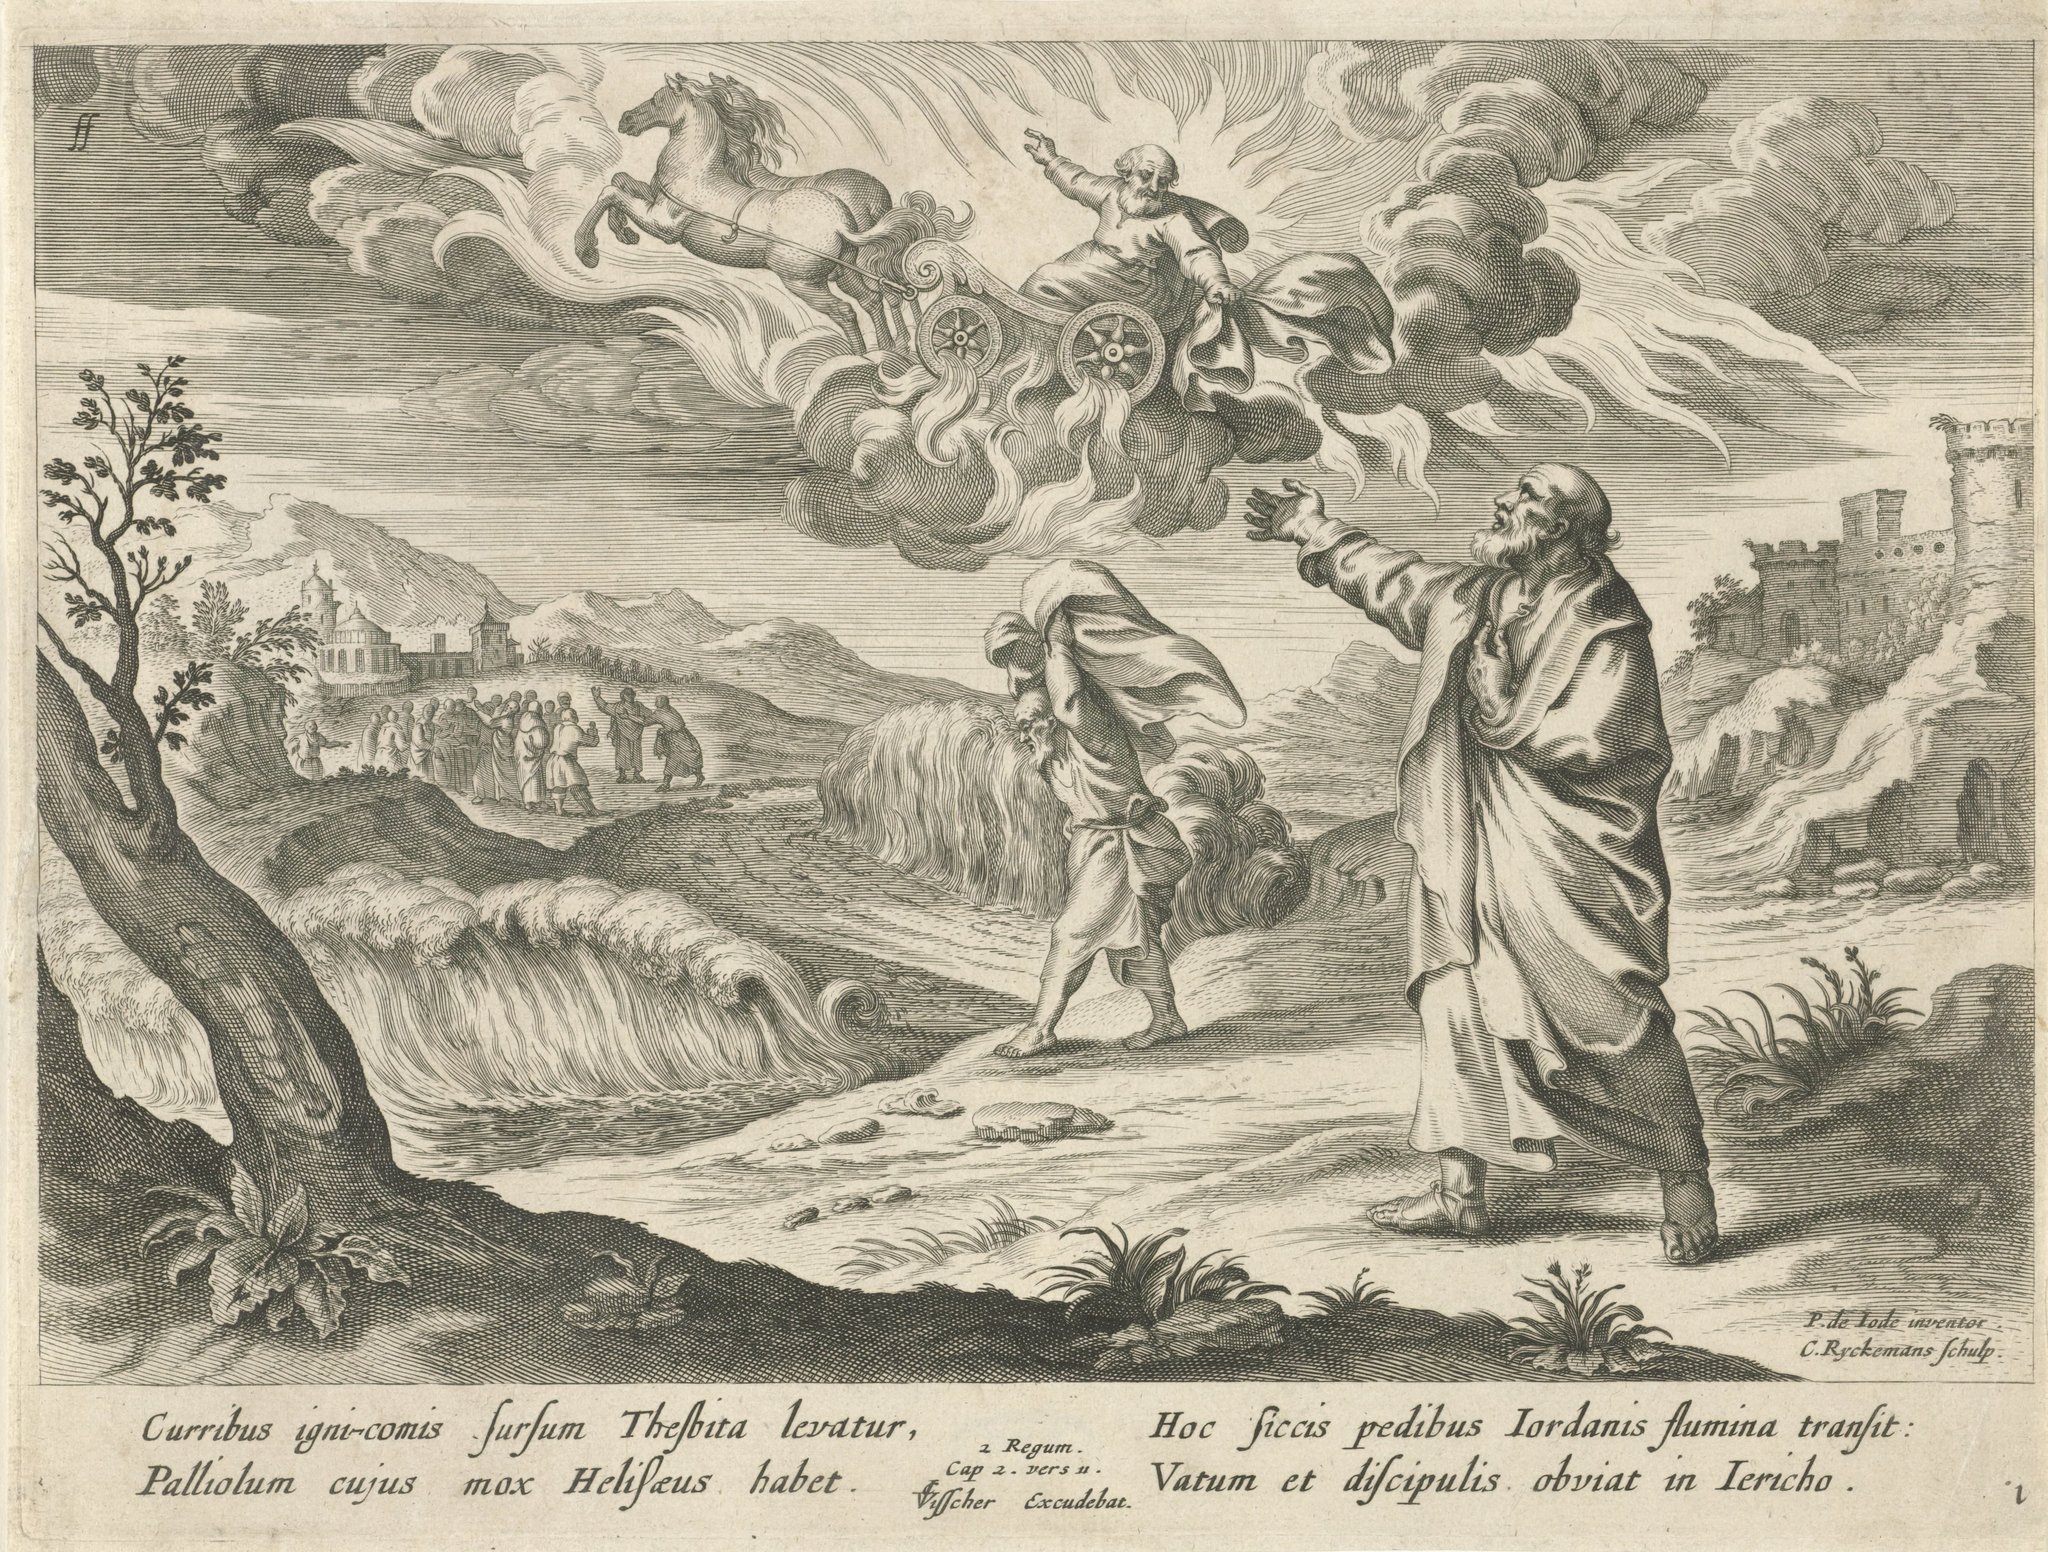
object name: print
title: Elisa ziet de hemelvaart van Elia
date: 1643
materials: paper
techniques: engraving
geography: amsterdam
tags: a chariot, horses of fire and a whirlwind appear and elijah is carried up into heaven; elijah's cloak falls (or he hands it over to elisha)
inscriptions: collector's mark: Lugt 2228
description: De profeet Elisa ontvangt de mantel van Elia die in een vurige wagen naar de hemel rijdt. Op de achtergrond slaat Elisa het water van de Jordaan met de mantel van Elia.